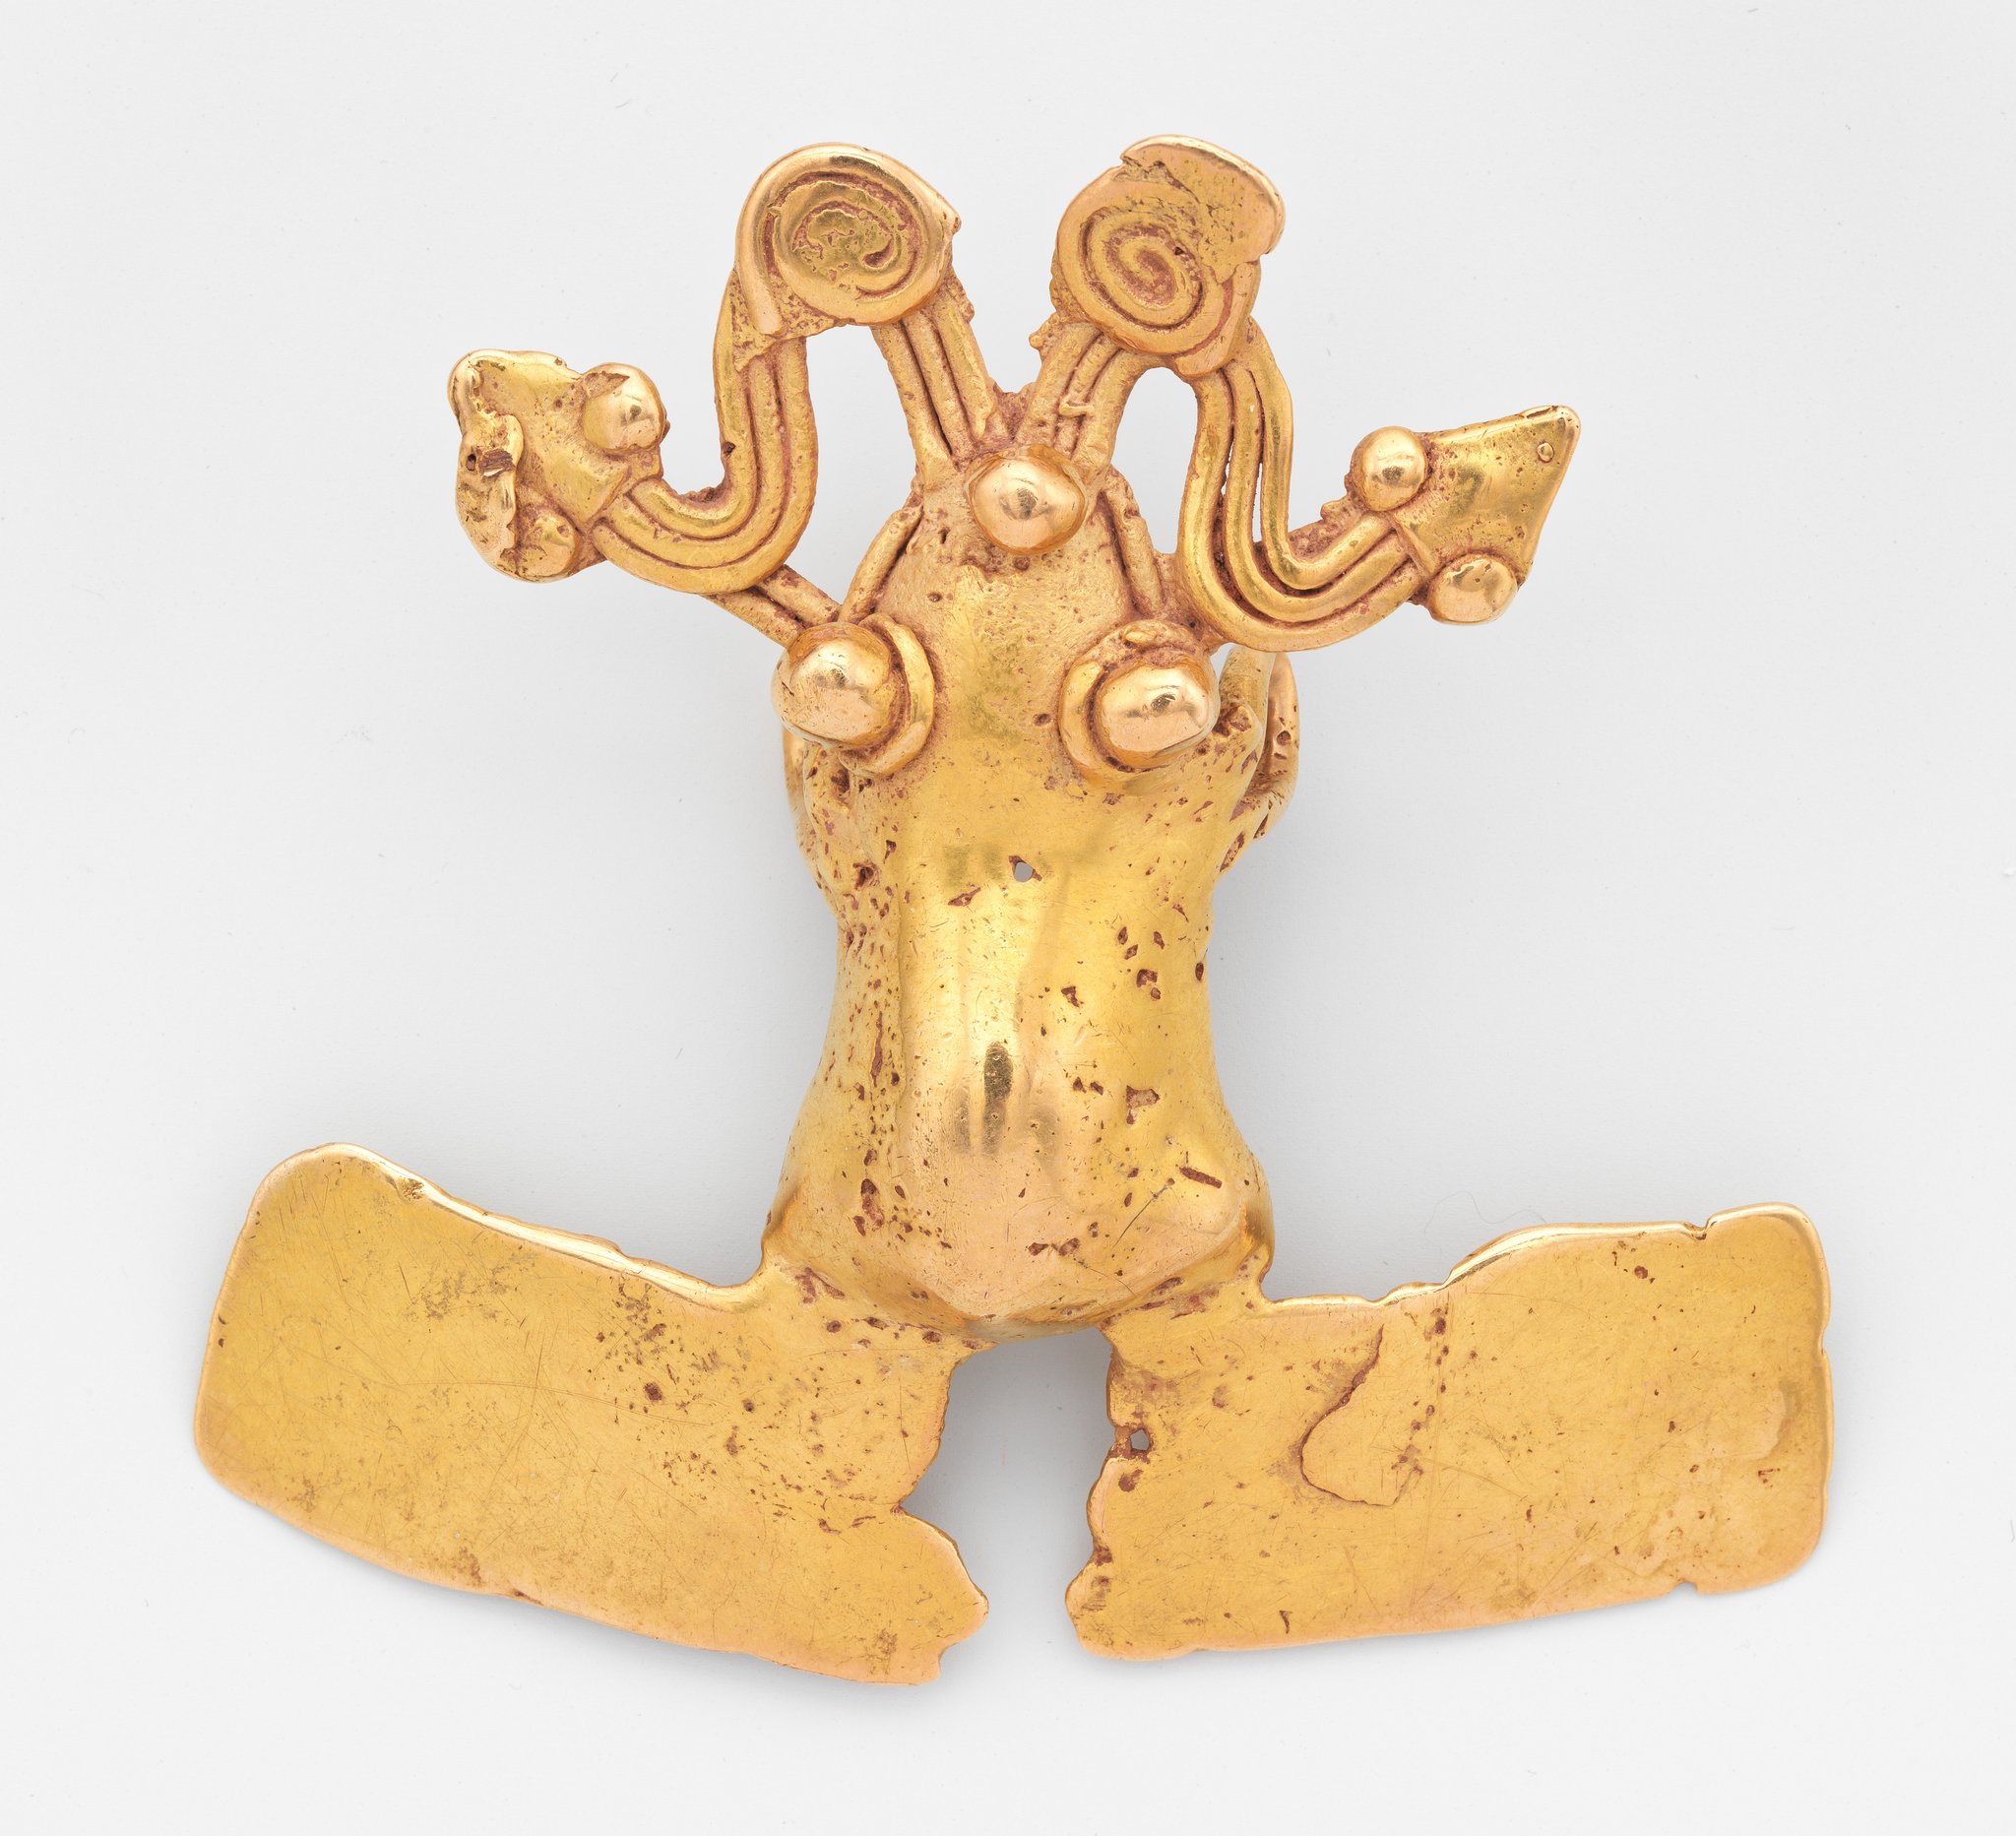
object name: pendant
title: Frog Pendant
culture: chiriqui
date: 1001-1600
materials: gold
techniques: casting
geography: costa rica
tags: frogs